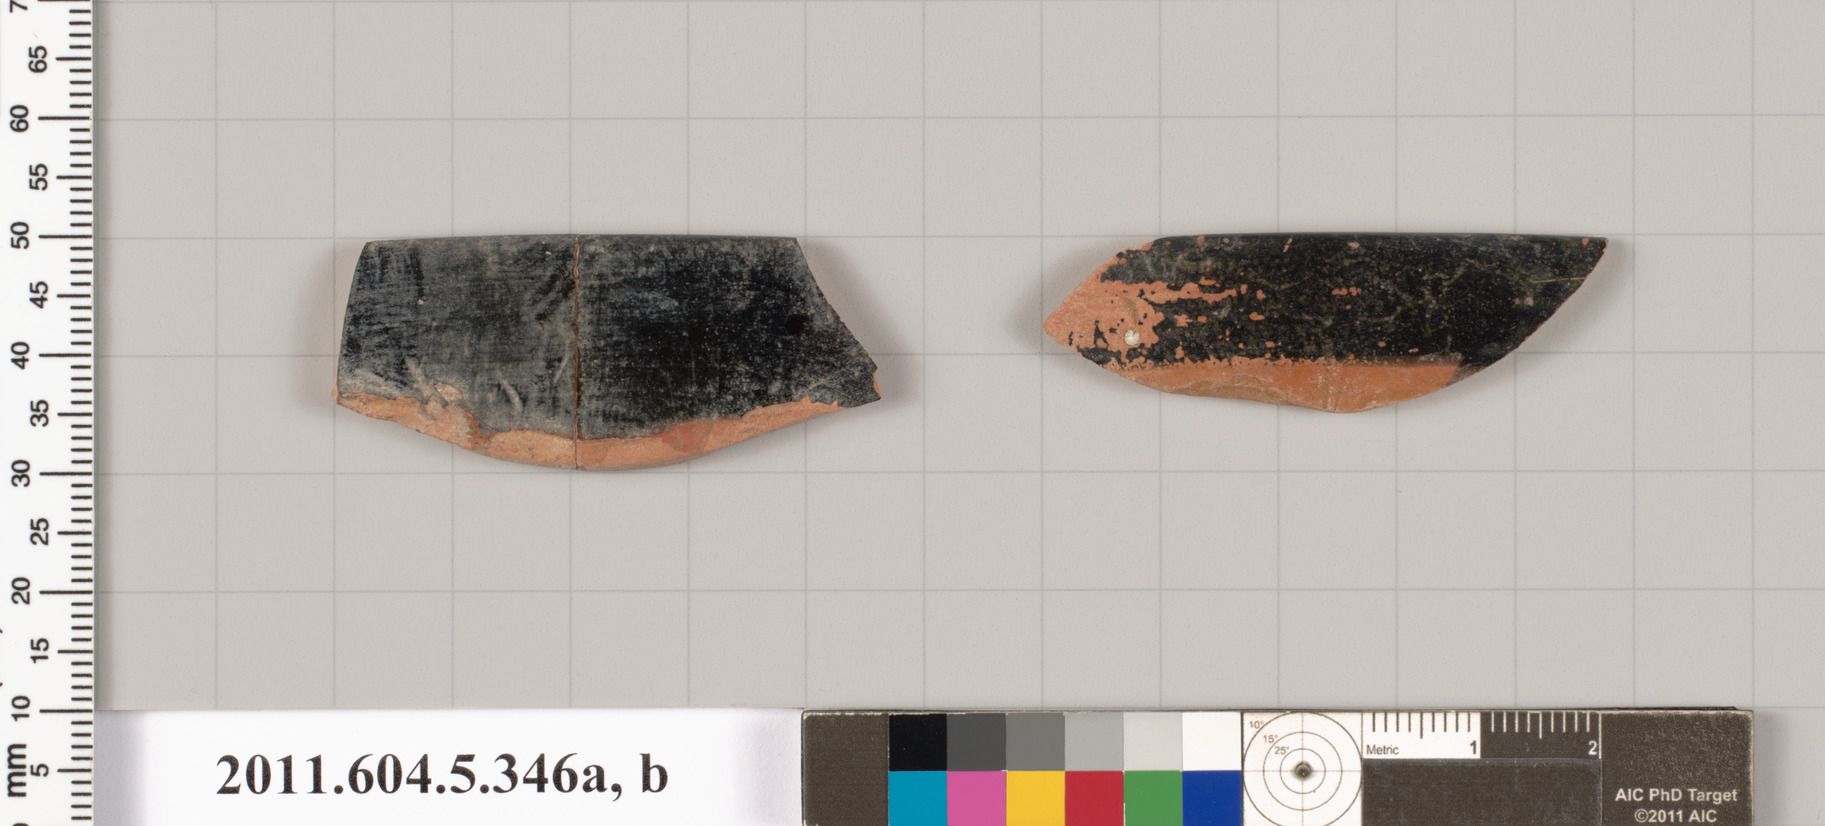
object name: kylix fragment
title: Terracotta rim fragments of kylikes (drinking cups)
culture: greek, attic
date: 600-401 BCE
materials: terracotta